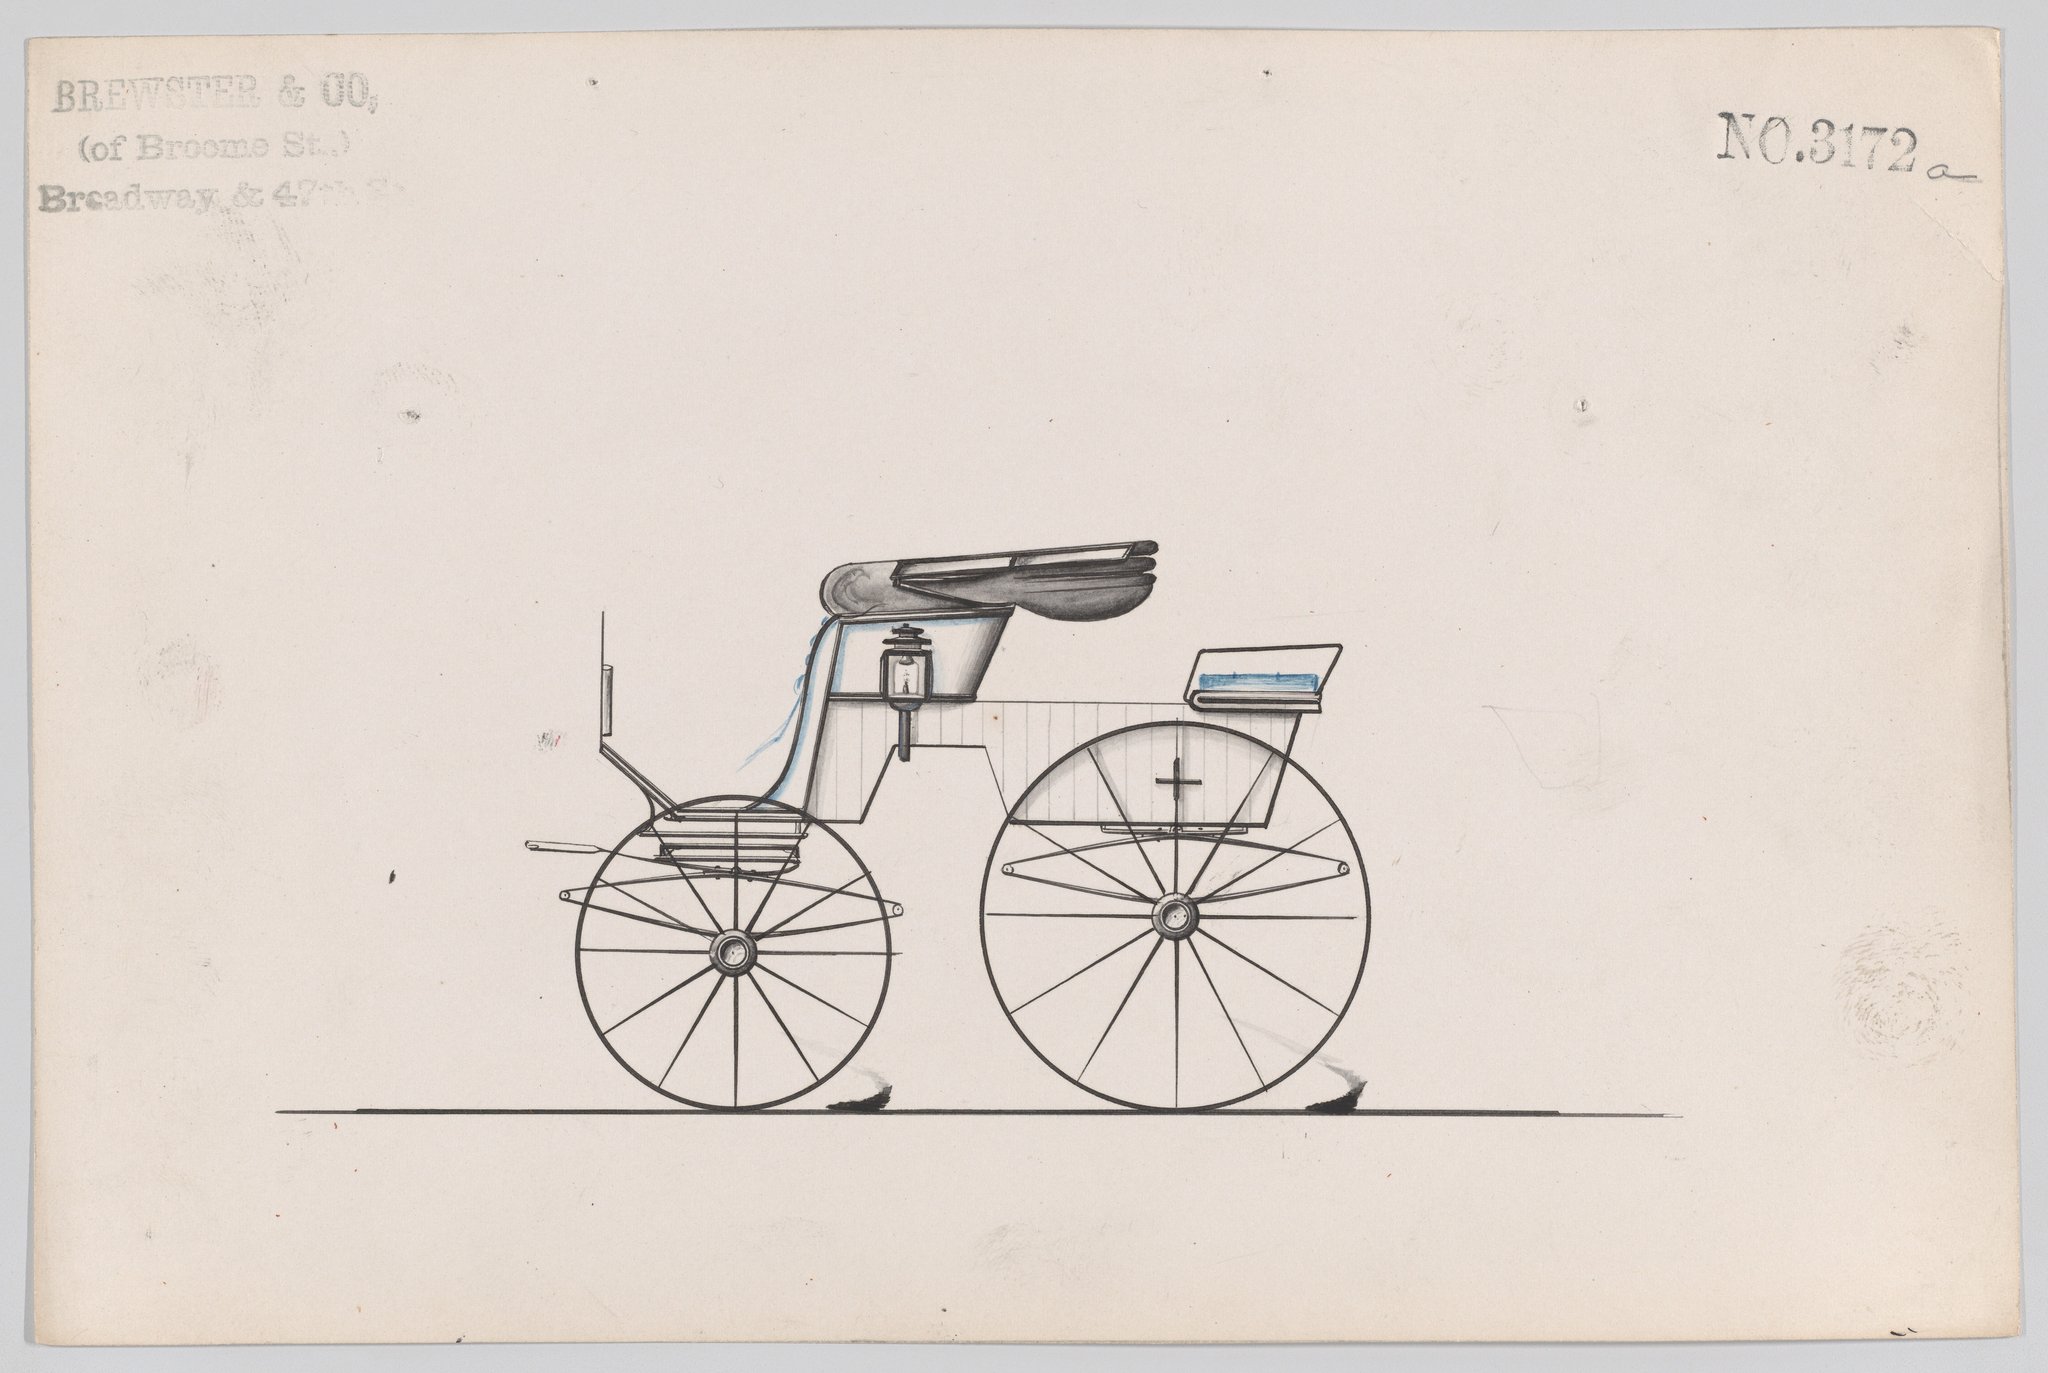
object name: drawing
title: Design for Stanhope Phaeton, no. 3172a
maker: brewster & co.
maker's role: manufacturer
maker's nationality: american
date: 1875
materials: gouache, graphite, ink, watercolor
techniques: pen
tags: carriages